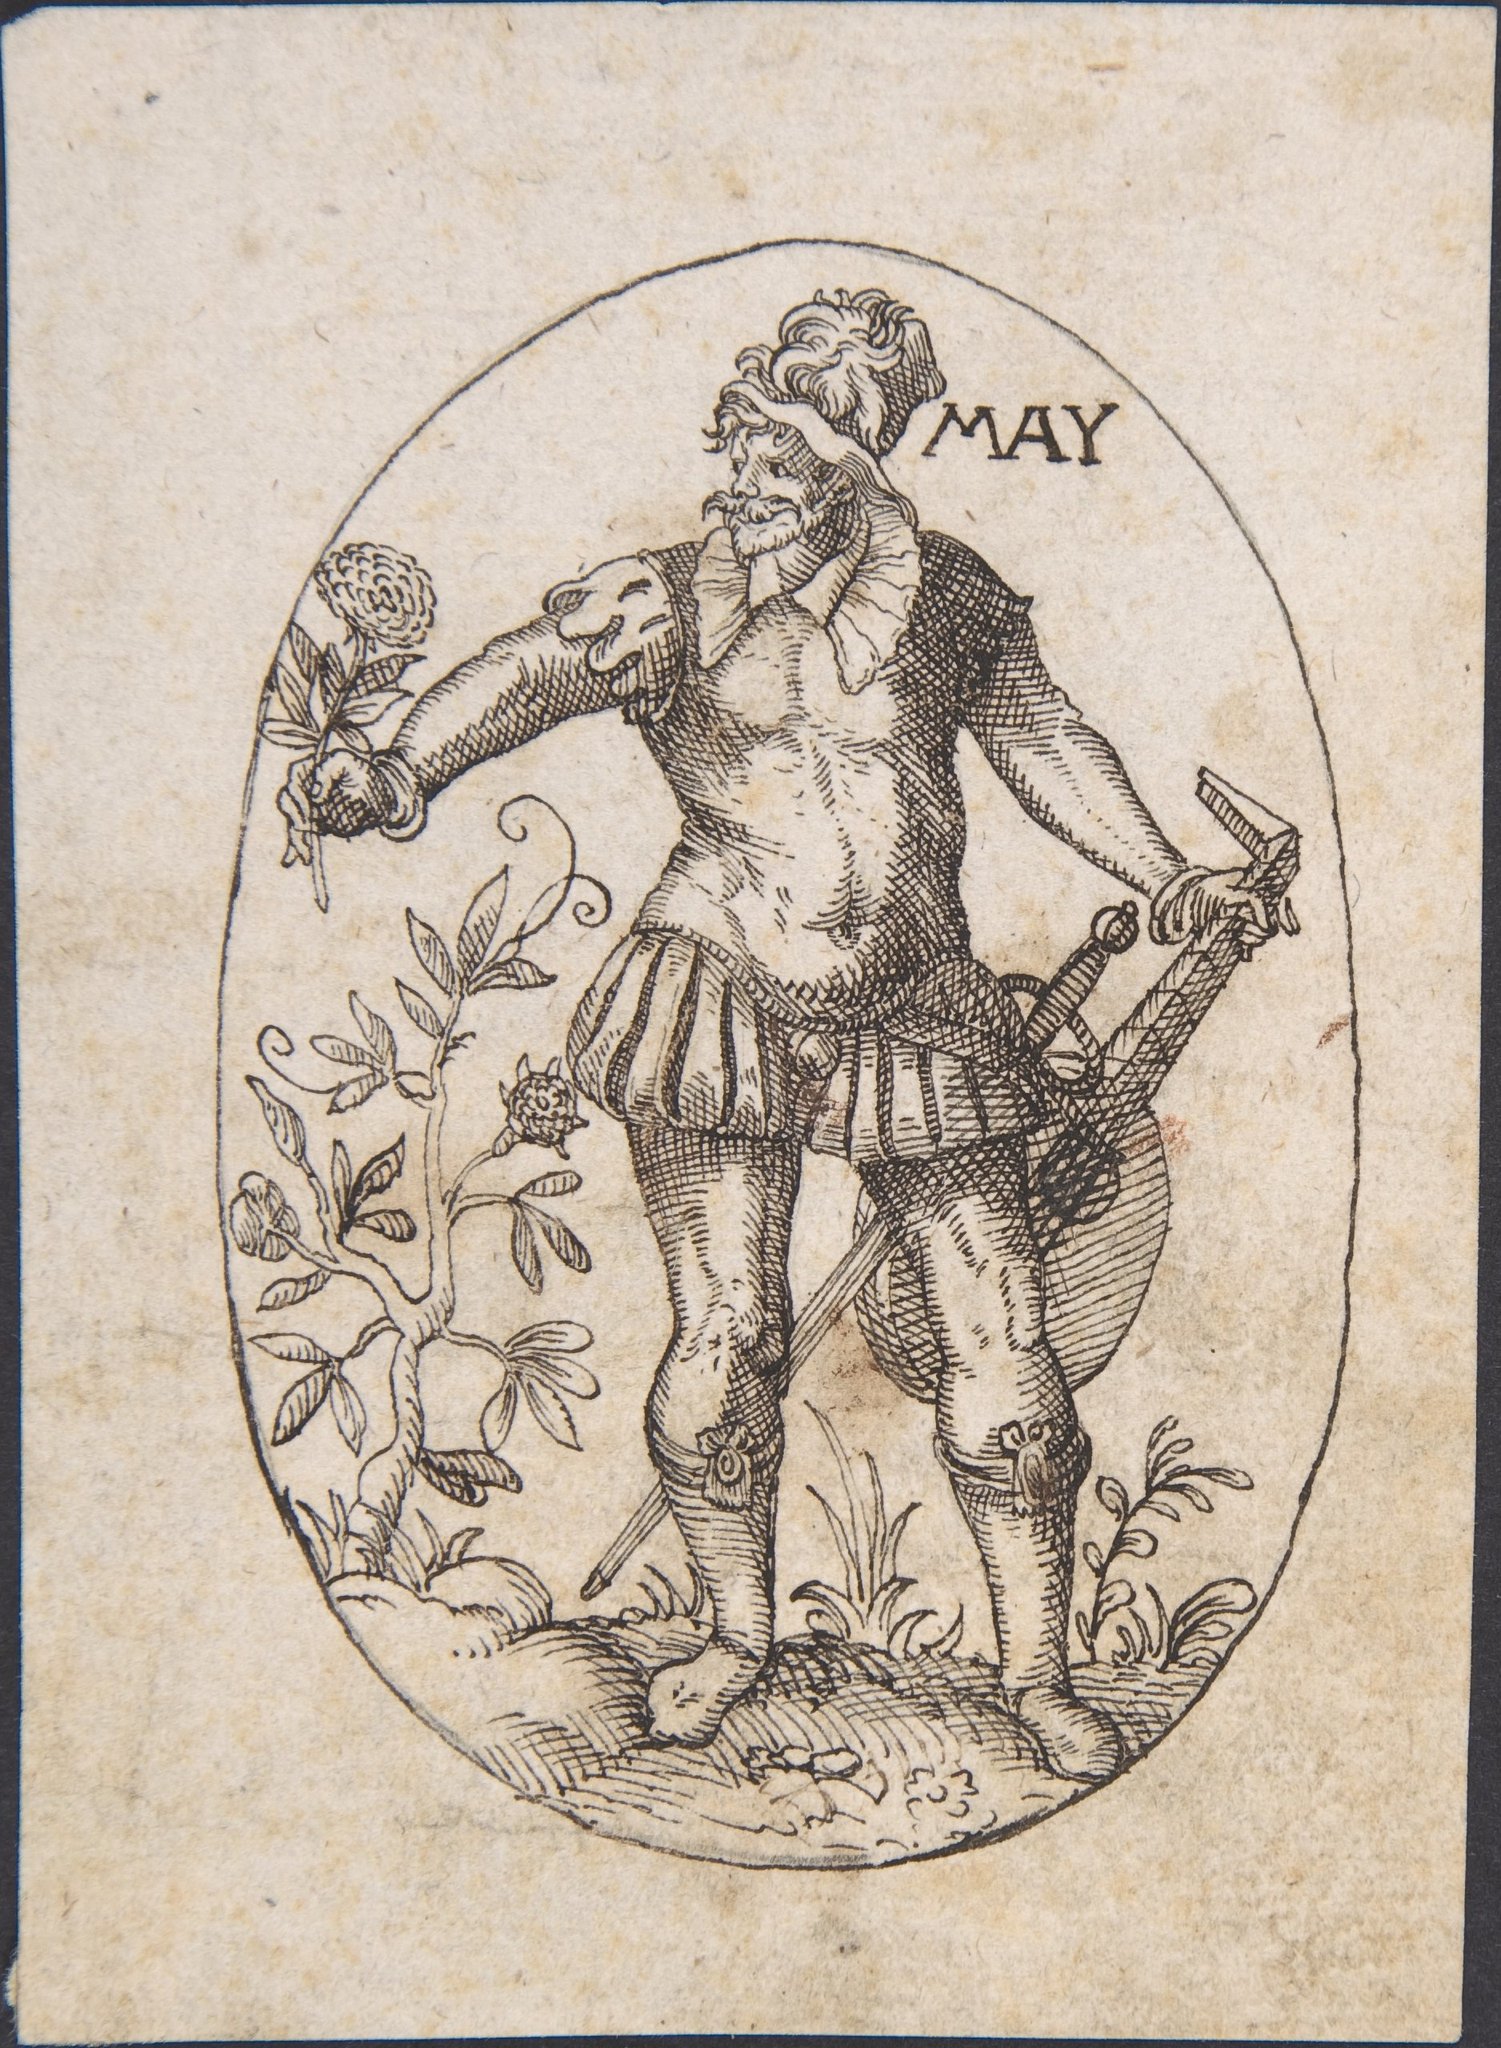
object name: drawing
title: The Month of May: An Elegant Man Holding a Flower and Lute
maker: erasmus hornick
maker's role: artist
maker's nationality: netherlandish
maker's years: 1501-1583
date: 1501-1600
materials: chalk, ink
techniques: pen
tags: musical instruments,swords,men,flowers,plants